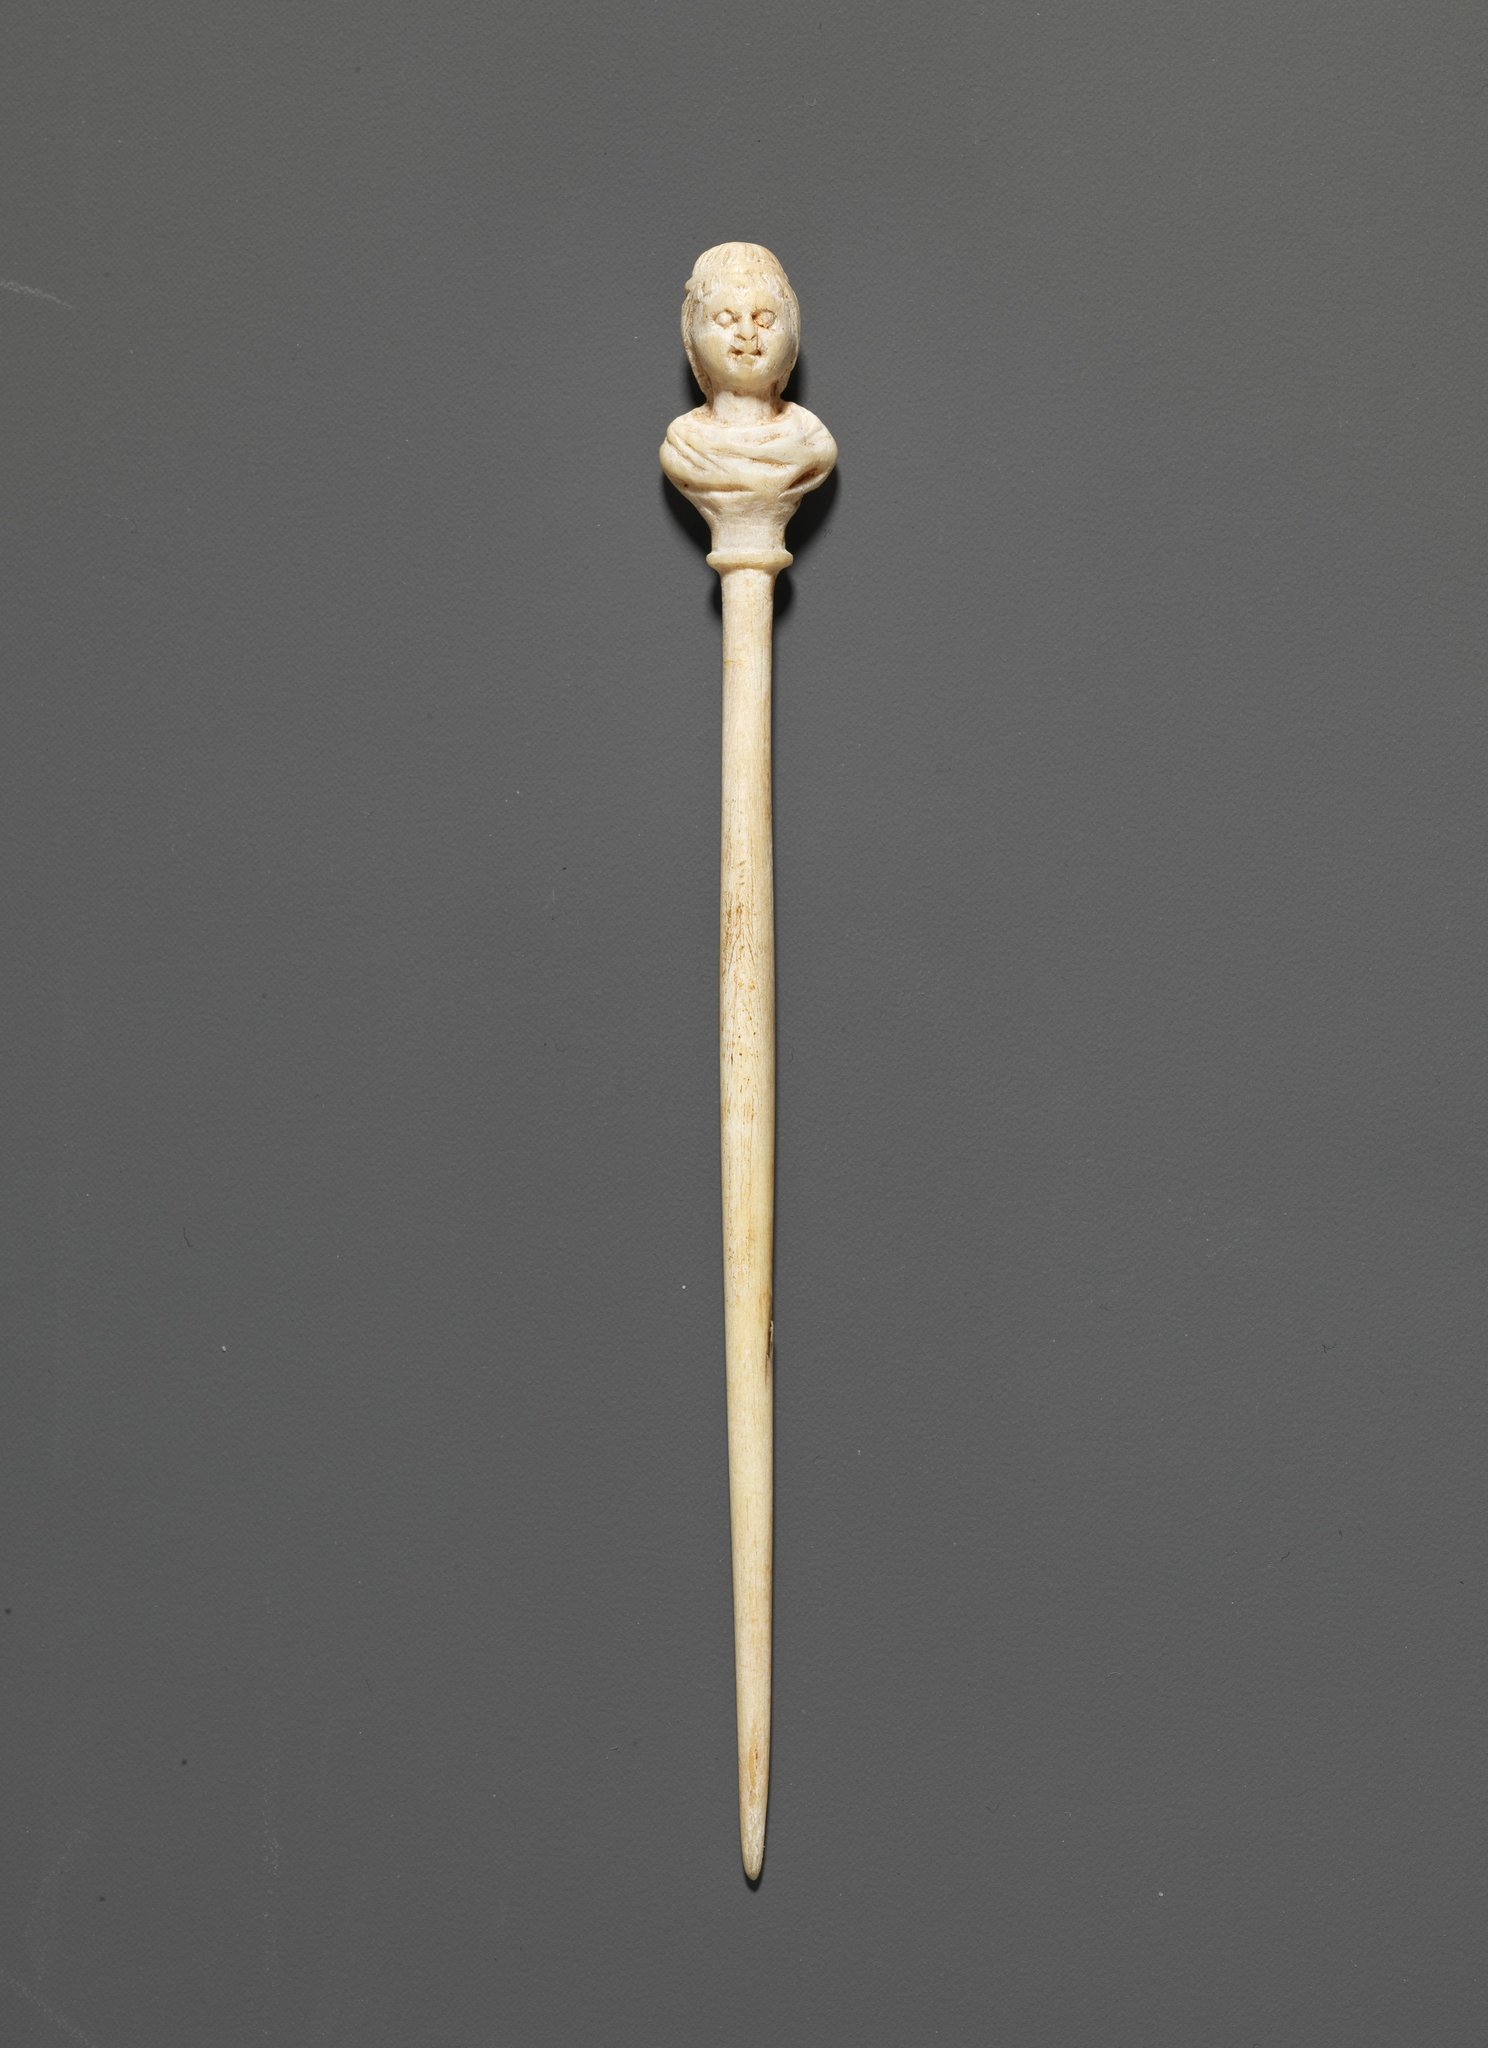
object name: pin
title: Bone hairpin with female head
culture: roman, cypriot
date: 1-400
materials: bone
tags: heads